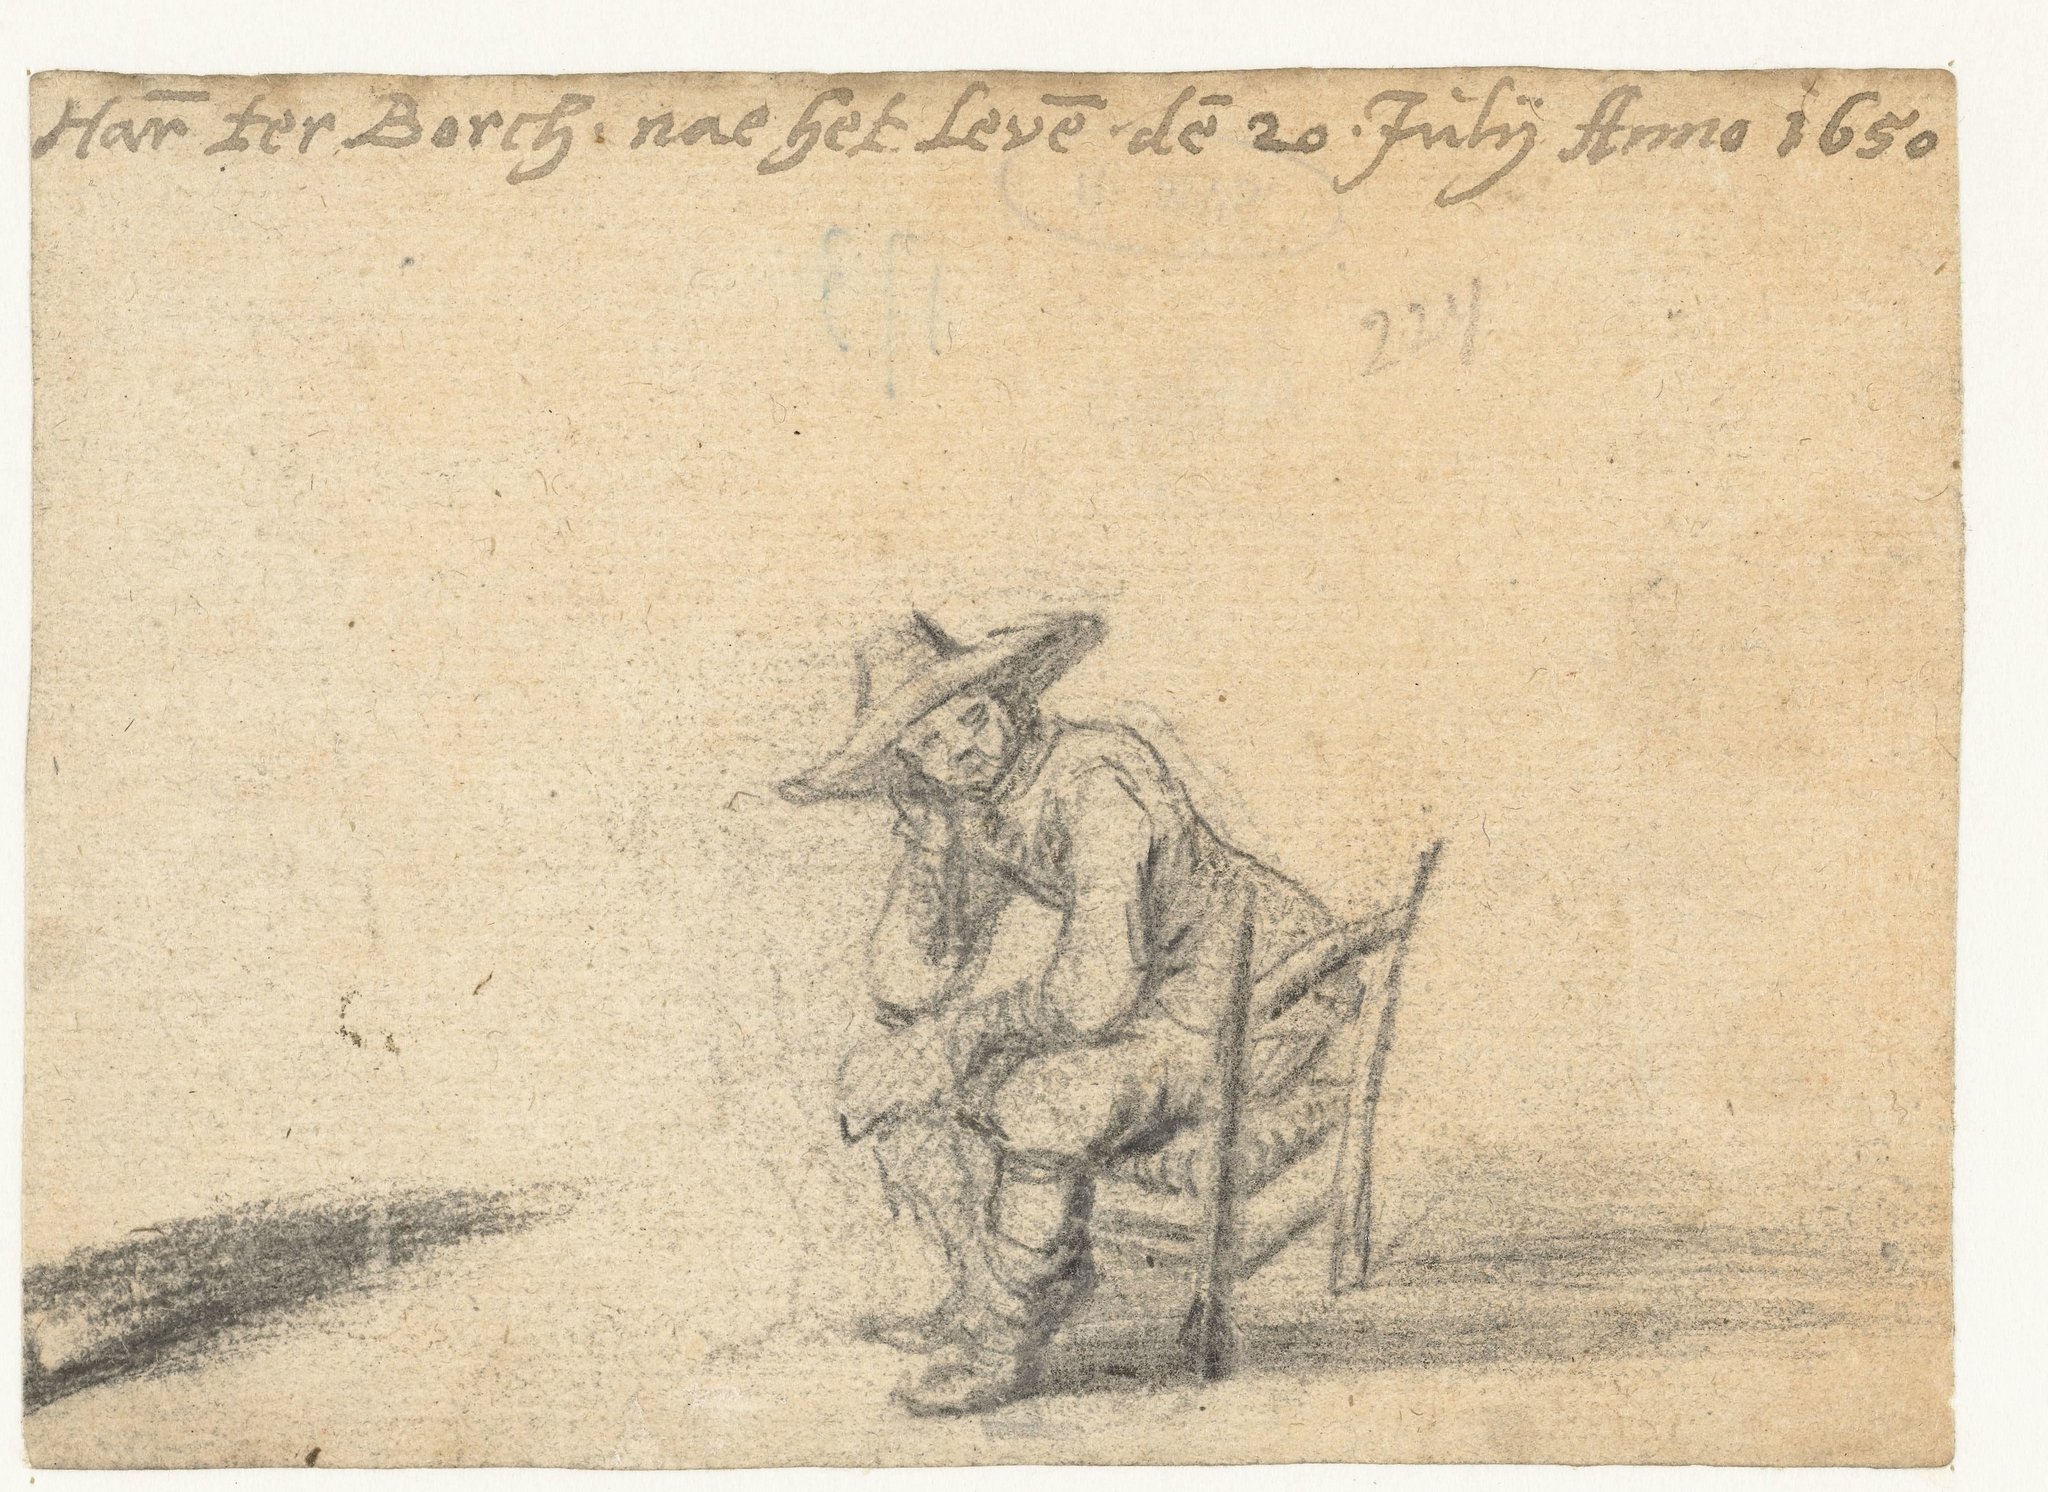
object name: drawing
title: Jongeman zittend op een stoel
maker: harmen ter borch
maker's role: draughtsman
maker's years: 1638-1677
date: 1650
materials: chalk, pencil, paper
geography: zwolle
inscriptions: annotation: ‘Har[men] ter Borch. nae het leve[n]. den 20.Julij Anno 1650’